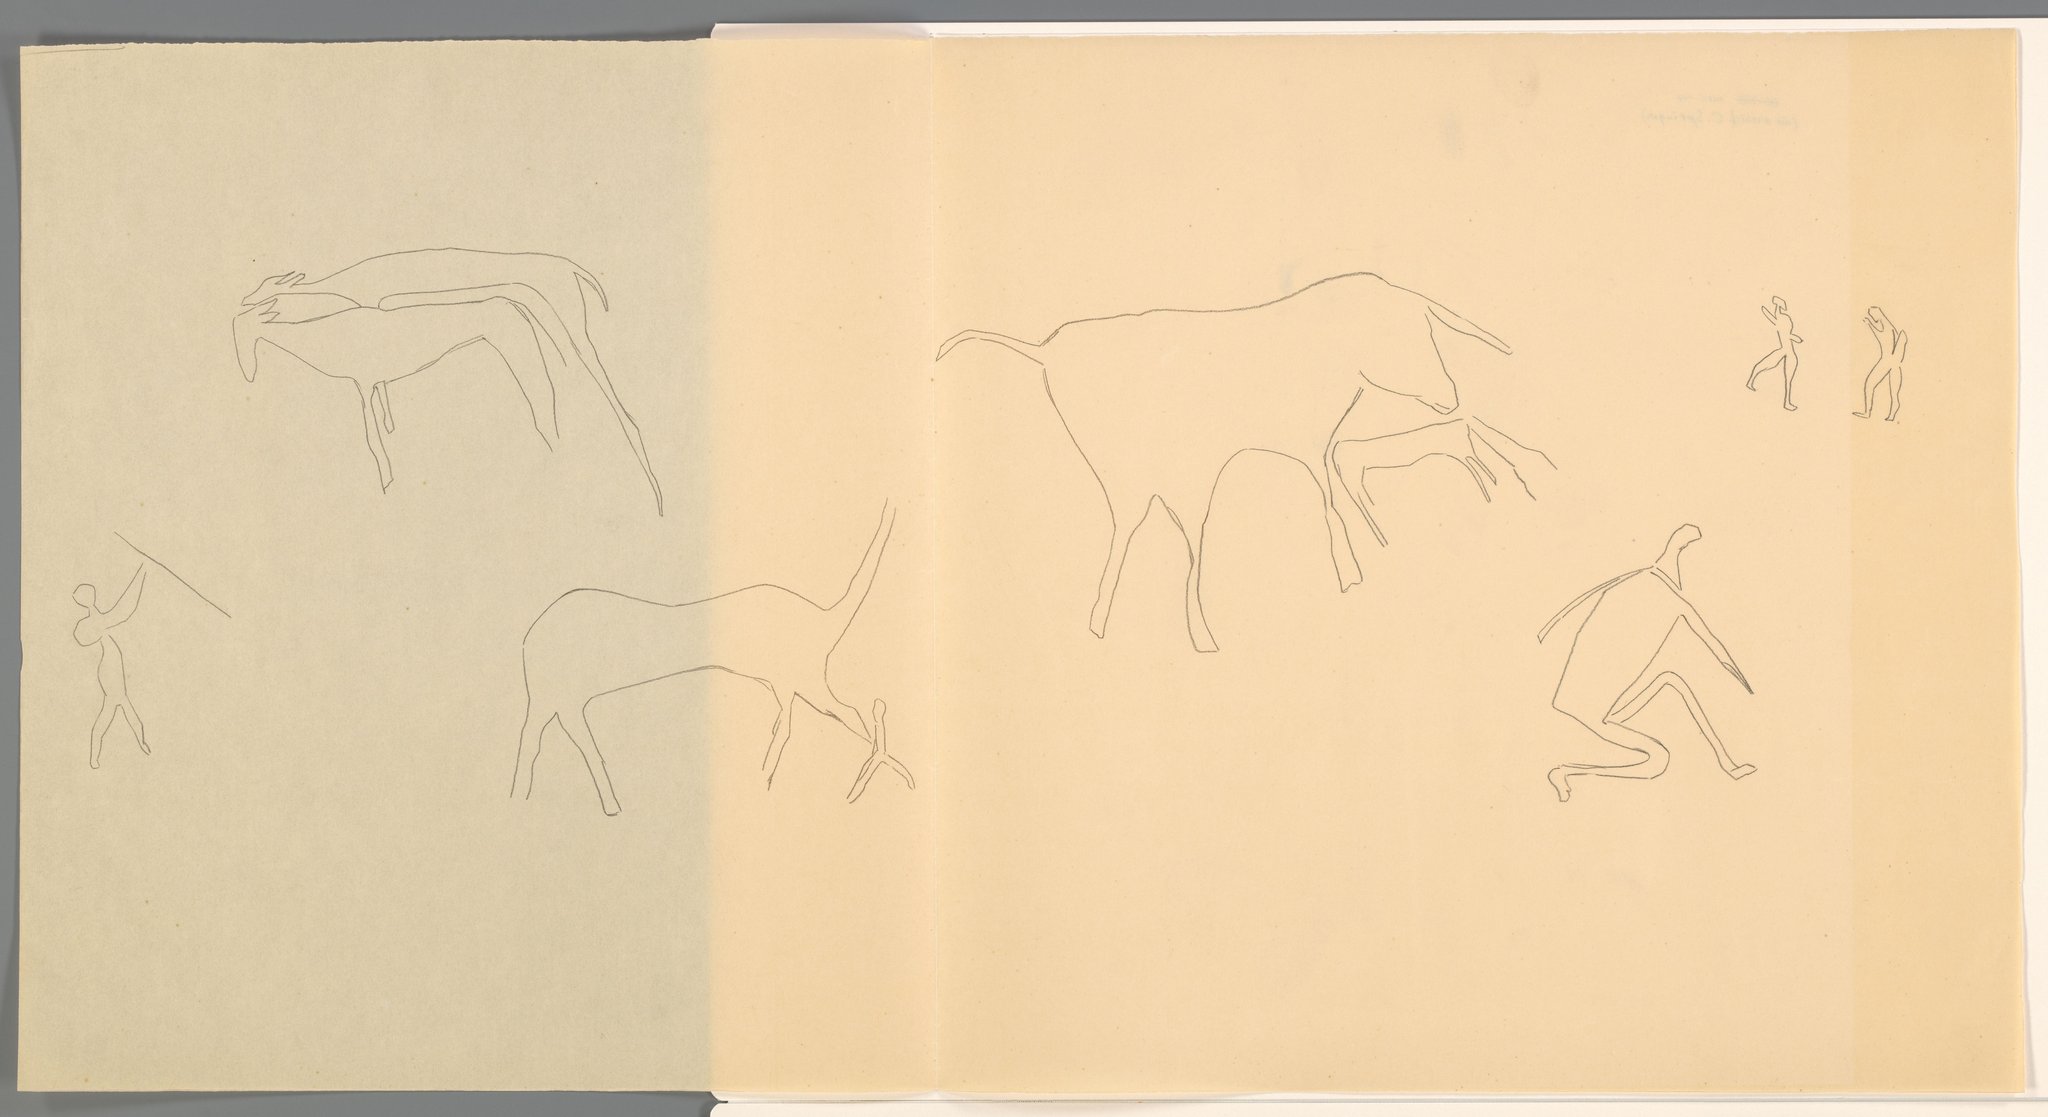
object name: drawing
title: Studieblad met dieren en figuren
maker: Anonymous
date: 1849-1949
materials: paper, pencil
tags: animals, postures of the human figure